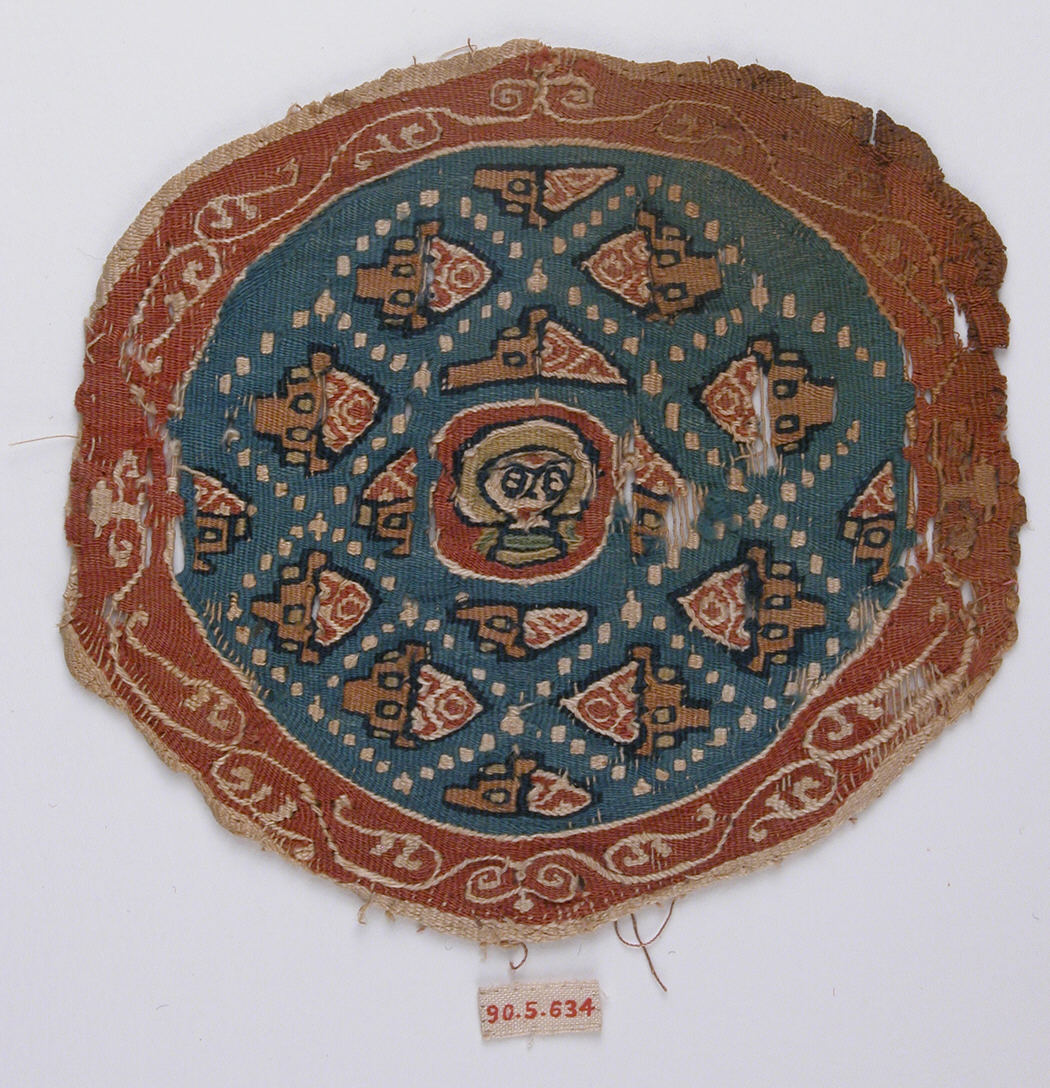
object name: textile fragment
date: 601-800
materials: linen, wool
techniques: weave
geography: egypt